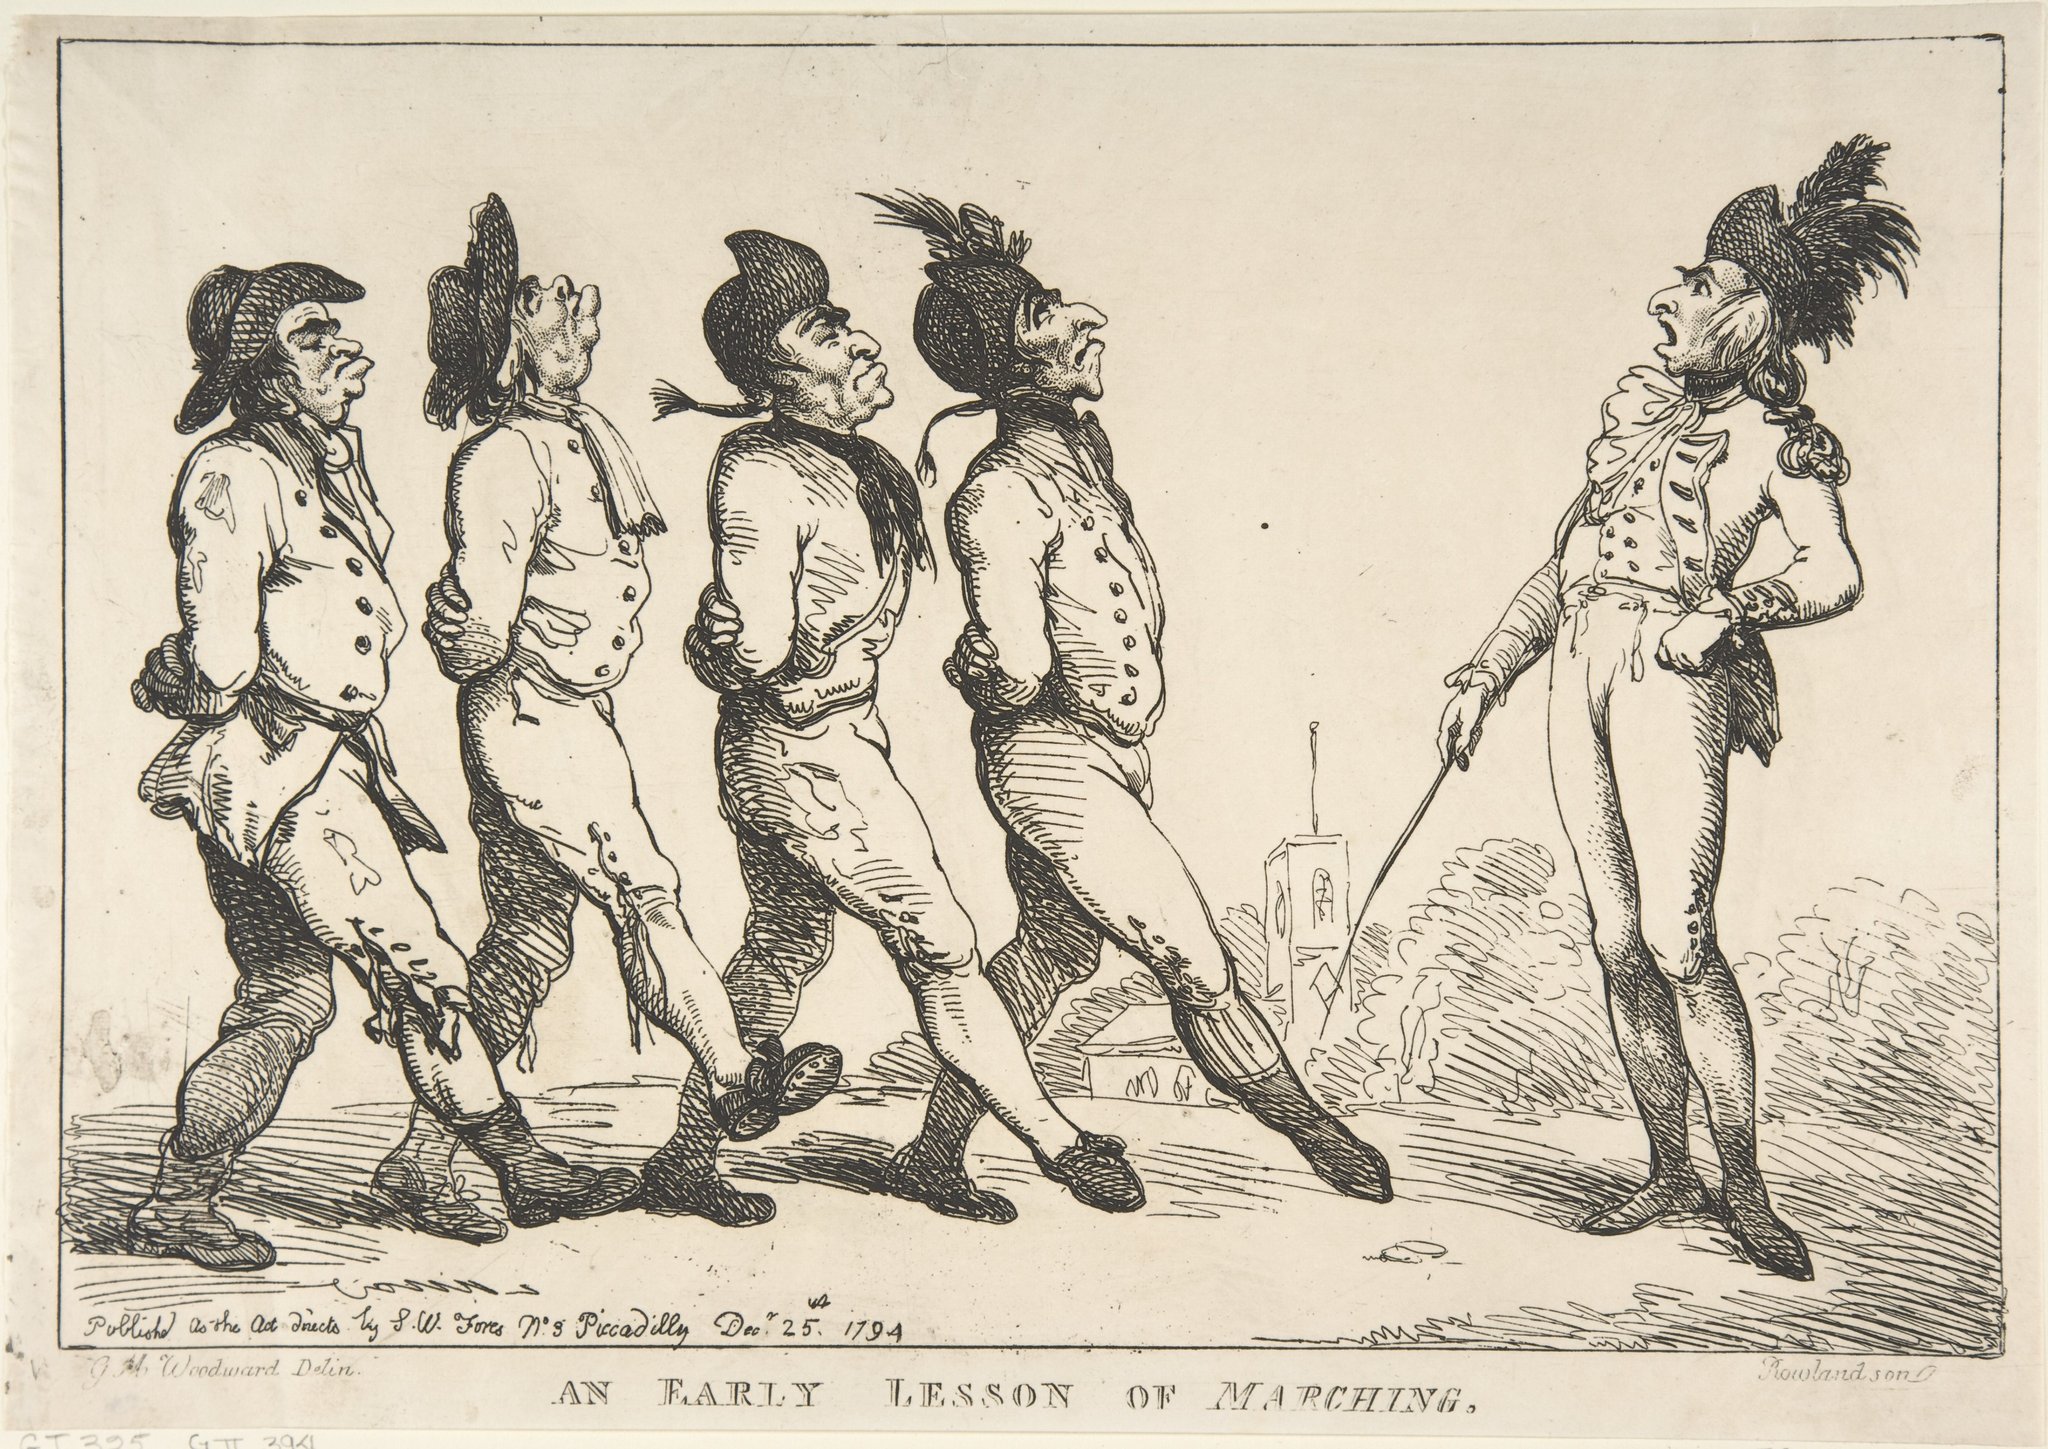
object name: print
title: An Early Lesson of Marching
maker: thomas rowlandson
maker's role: artist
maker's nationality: british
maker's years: 1757-1827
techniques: etching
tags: men